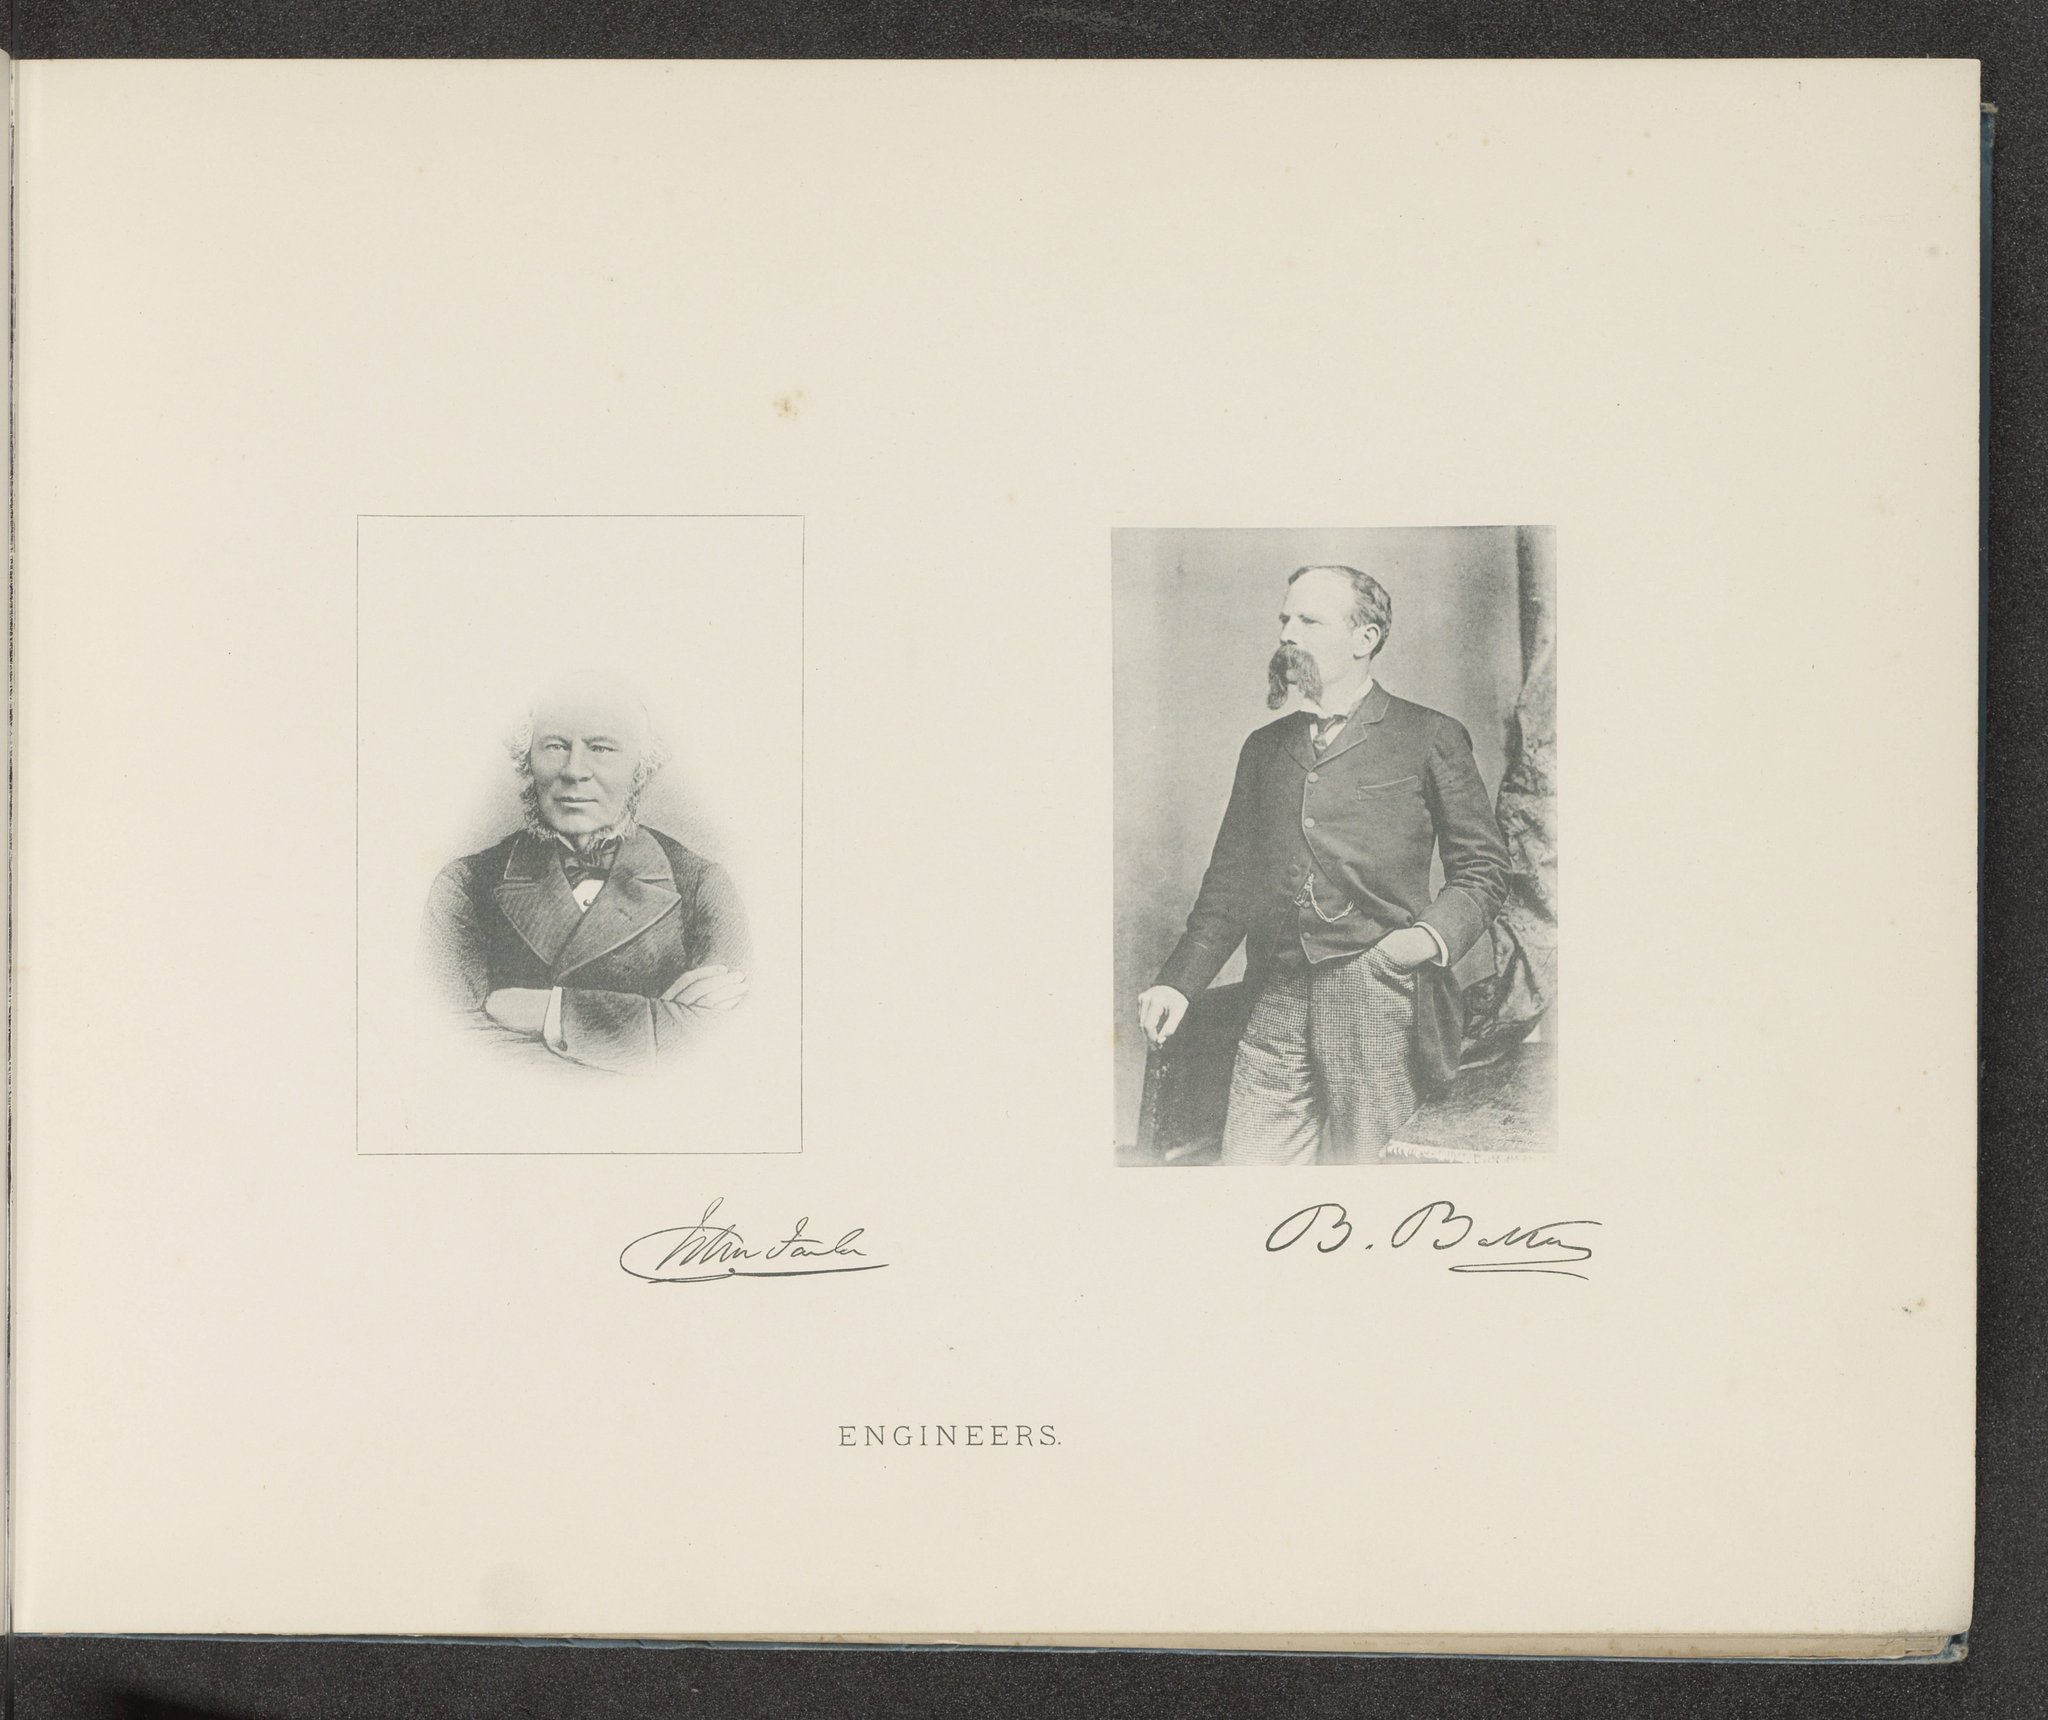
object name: photomechanical print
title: Engineers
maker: Anonymous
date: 1880-1890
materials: paper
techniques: photograph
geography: united kingdom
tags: engineering, historical persons (portraits and scenes from the life)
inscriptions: annotation